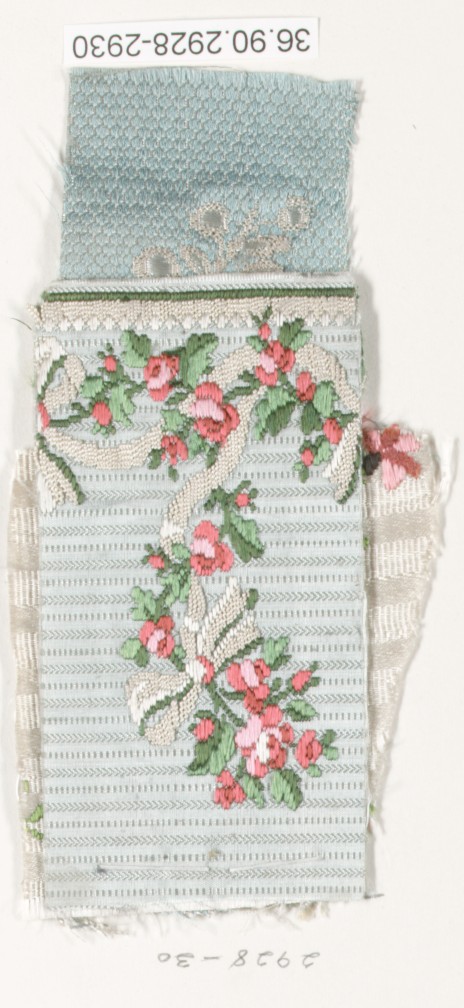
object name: piece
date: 1801-1900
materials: silk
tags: flowers